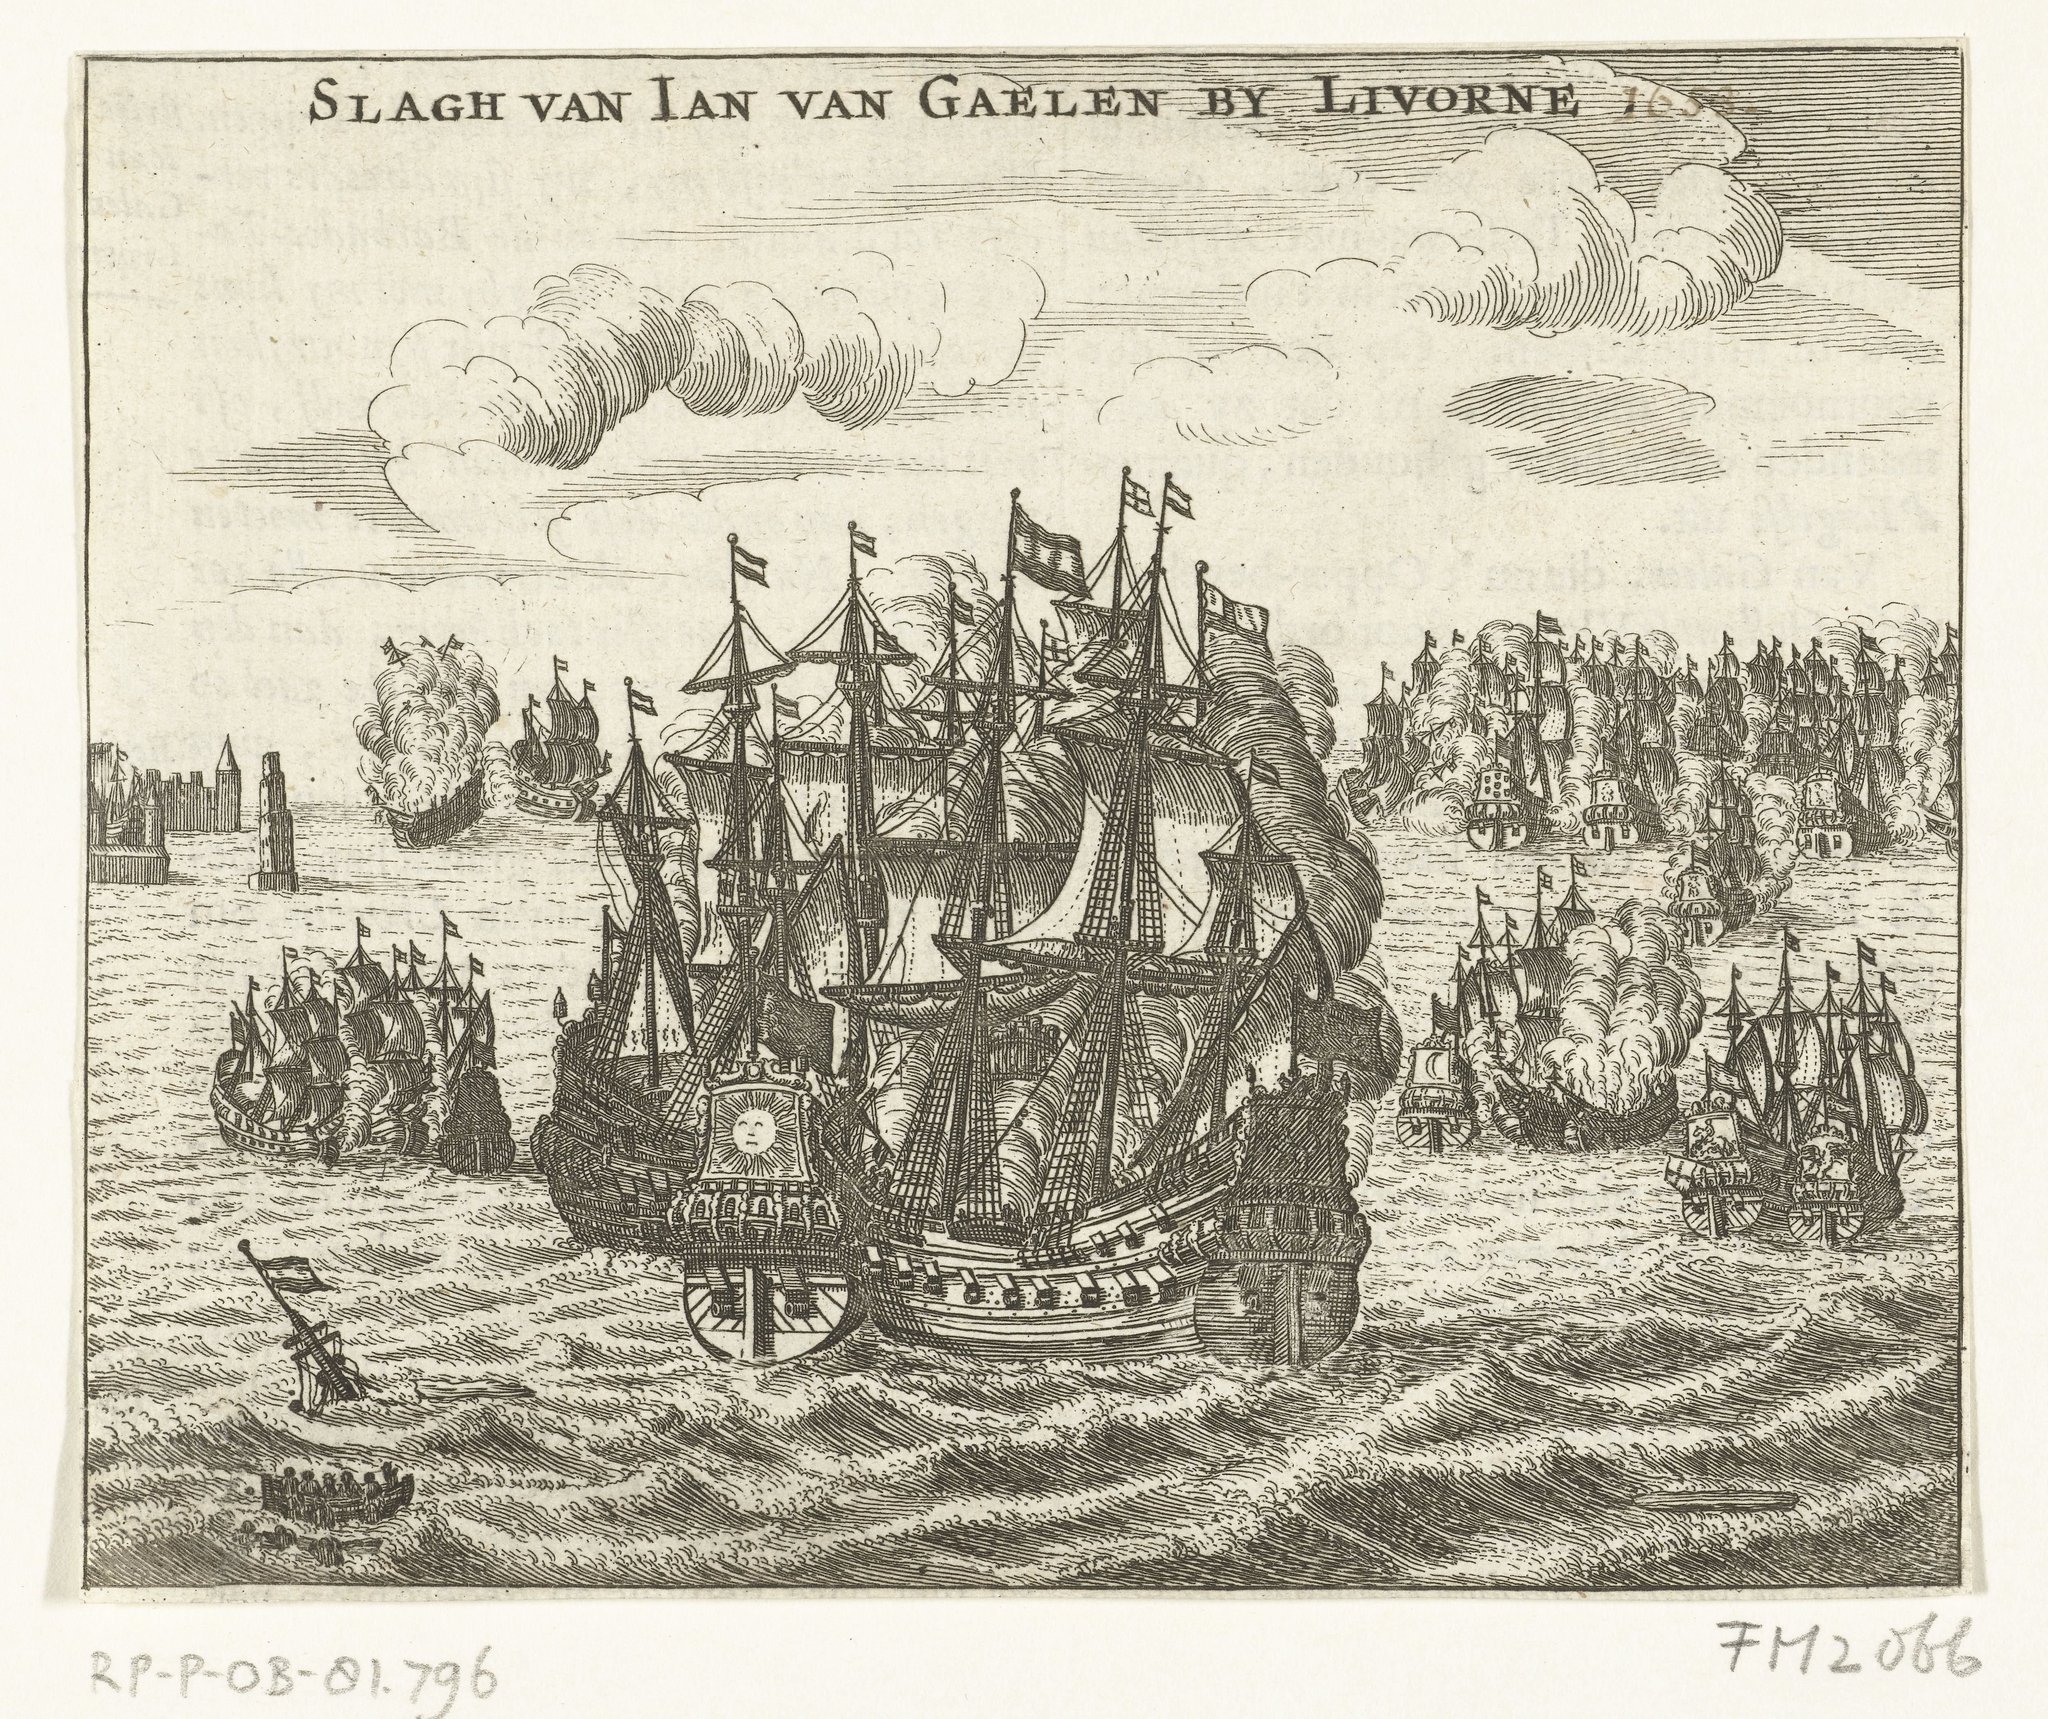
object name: history print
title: Slagh van Jan van Gaelen by Livorne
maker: Anonymous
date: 1662-1665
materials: paper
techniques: etching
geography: northern netherlands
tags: essen, battle (+ naval force), battle of leghorn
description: De zeeslag bij Livorno in de Eerste Engelse Oorlog tussen de Staatse vloot onder Johan van Galen en Cornelis Tromp en de Engelse vloot onder Henry Appleton en Richard Badiley, 14 maart 1653. Bij de slag raakt Johan van Galen gewond. Bedrukt op achterzijde met tekst in het Nederlands.